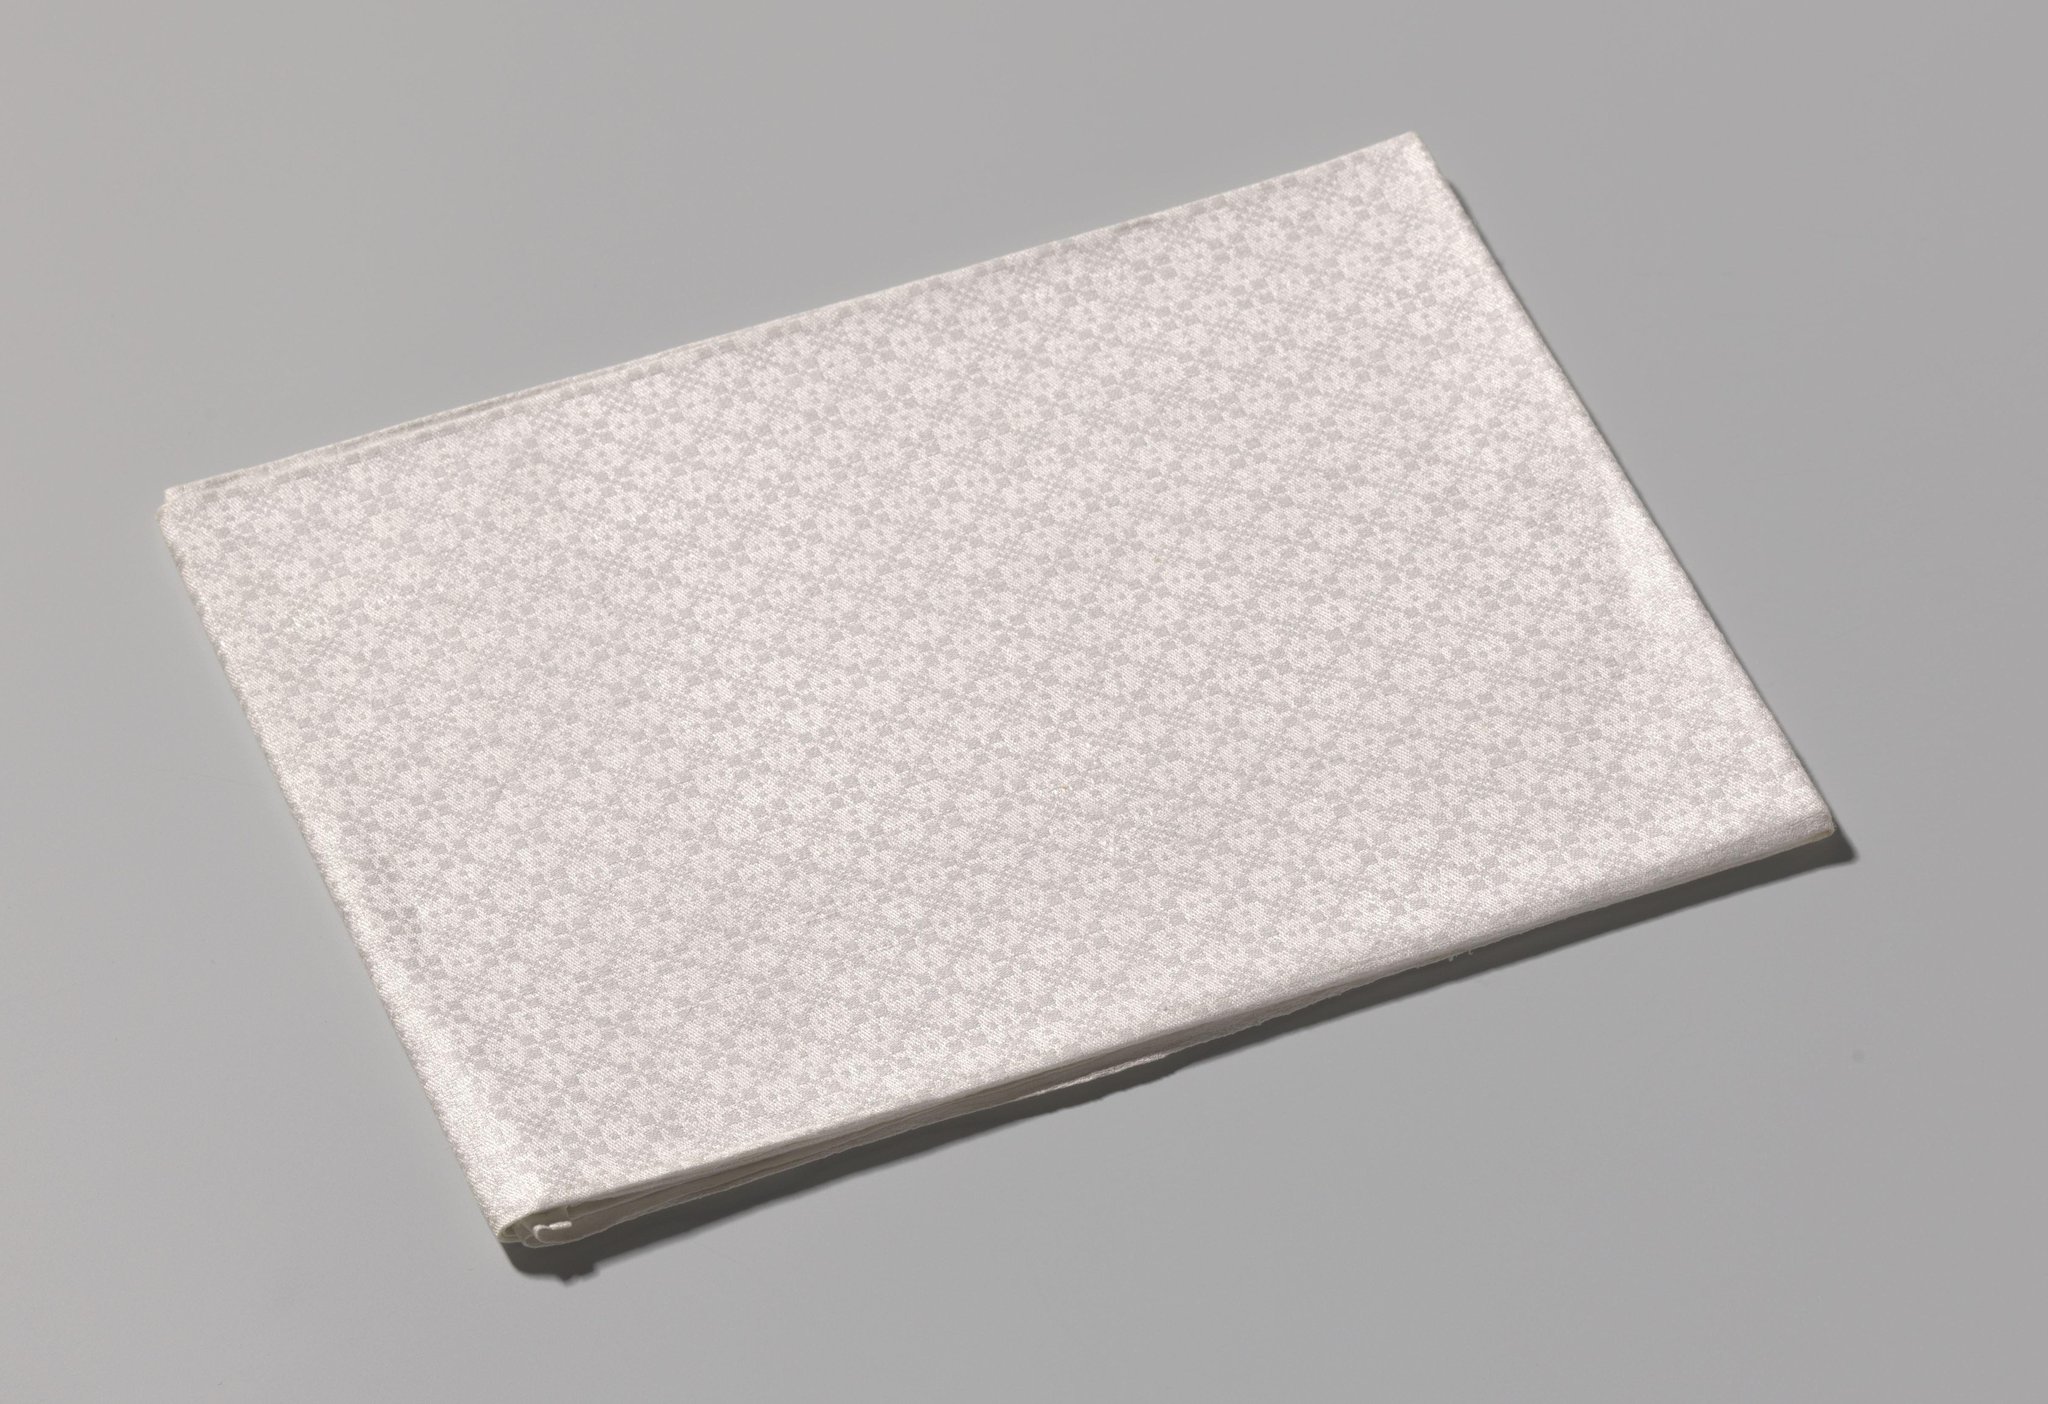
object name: napkin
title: Servet van linnen met pellenpatroon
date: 1627-1666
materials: linen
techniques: peeled fabric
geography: northern netherlands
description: wit linnen servet met pellen patroon, merk kroon IVG